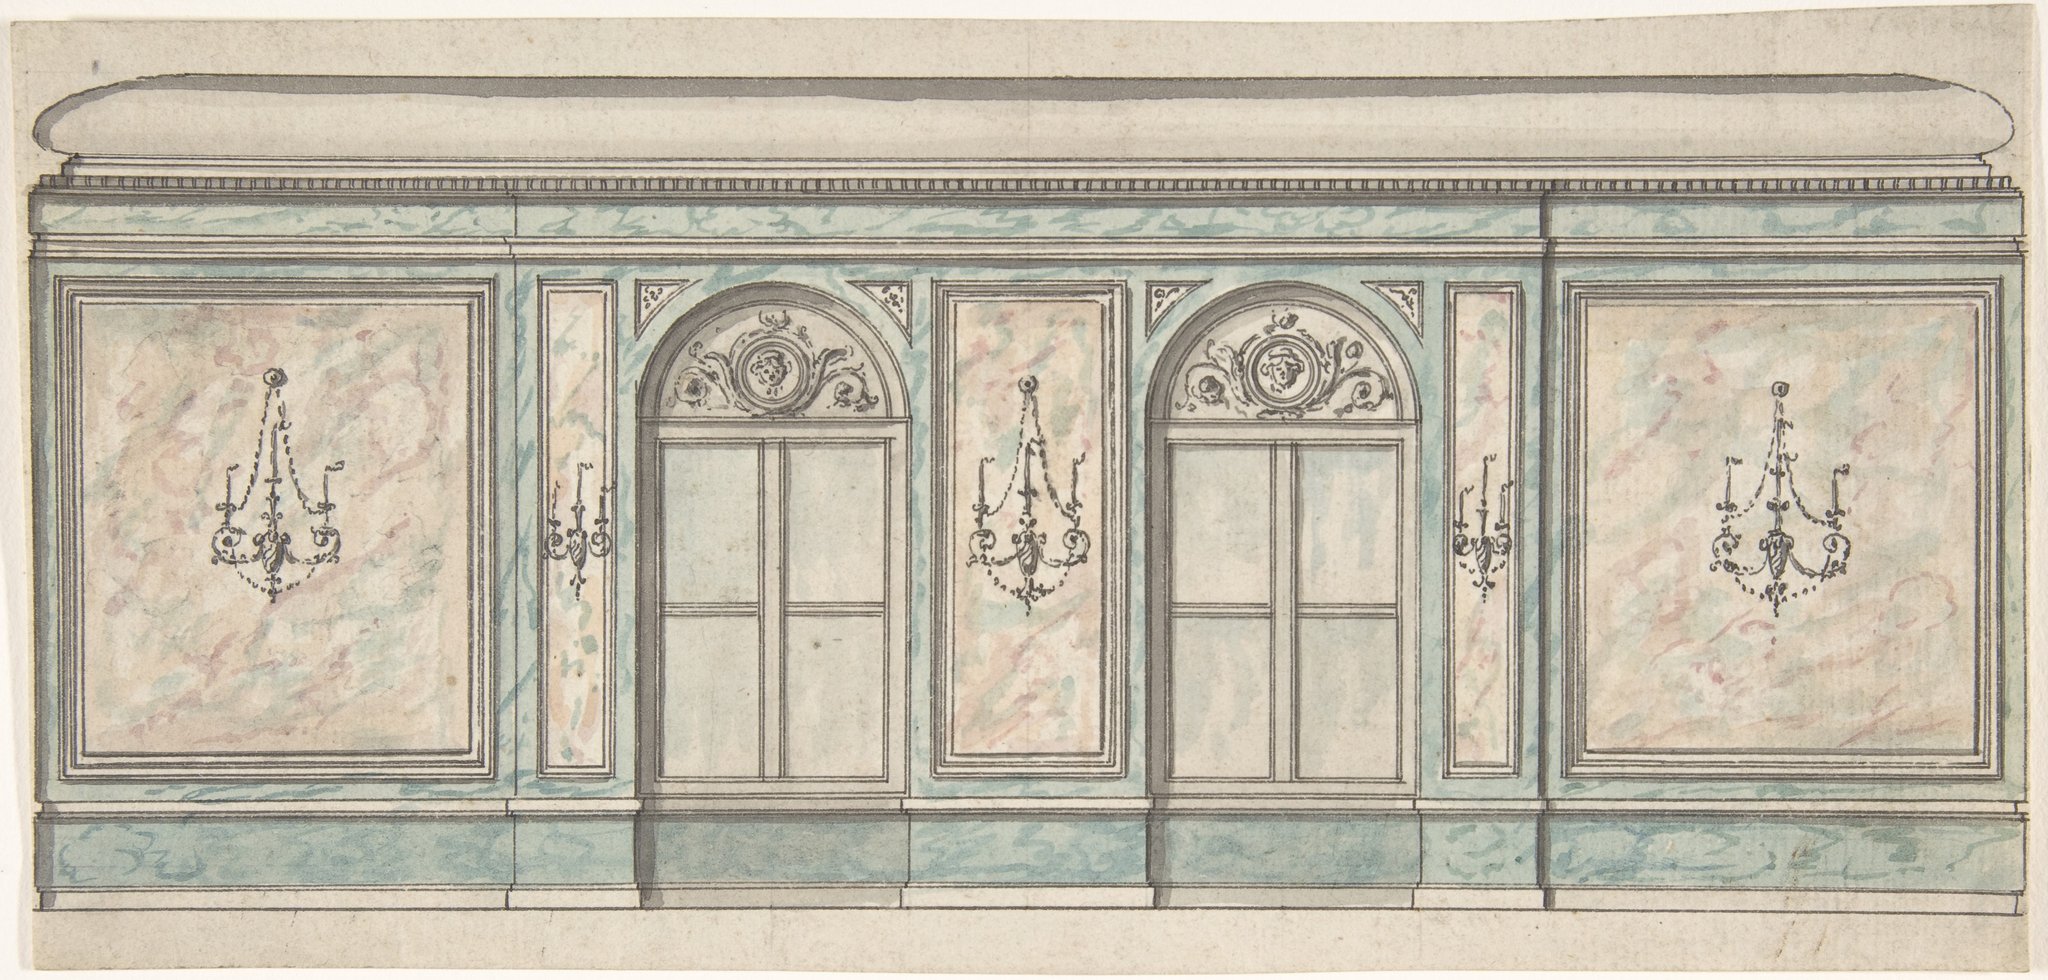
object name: drawing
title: Elevation of a Wall with Two Windows and Five Wall Lights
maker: anonymous, british, 19th century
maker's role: artist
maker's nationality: british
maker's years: 1800-1900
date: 1801-1900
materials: ink, watercolor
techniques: pen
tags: architecture